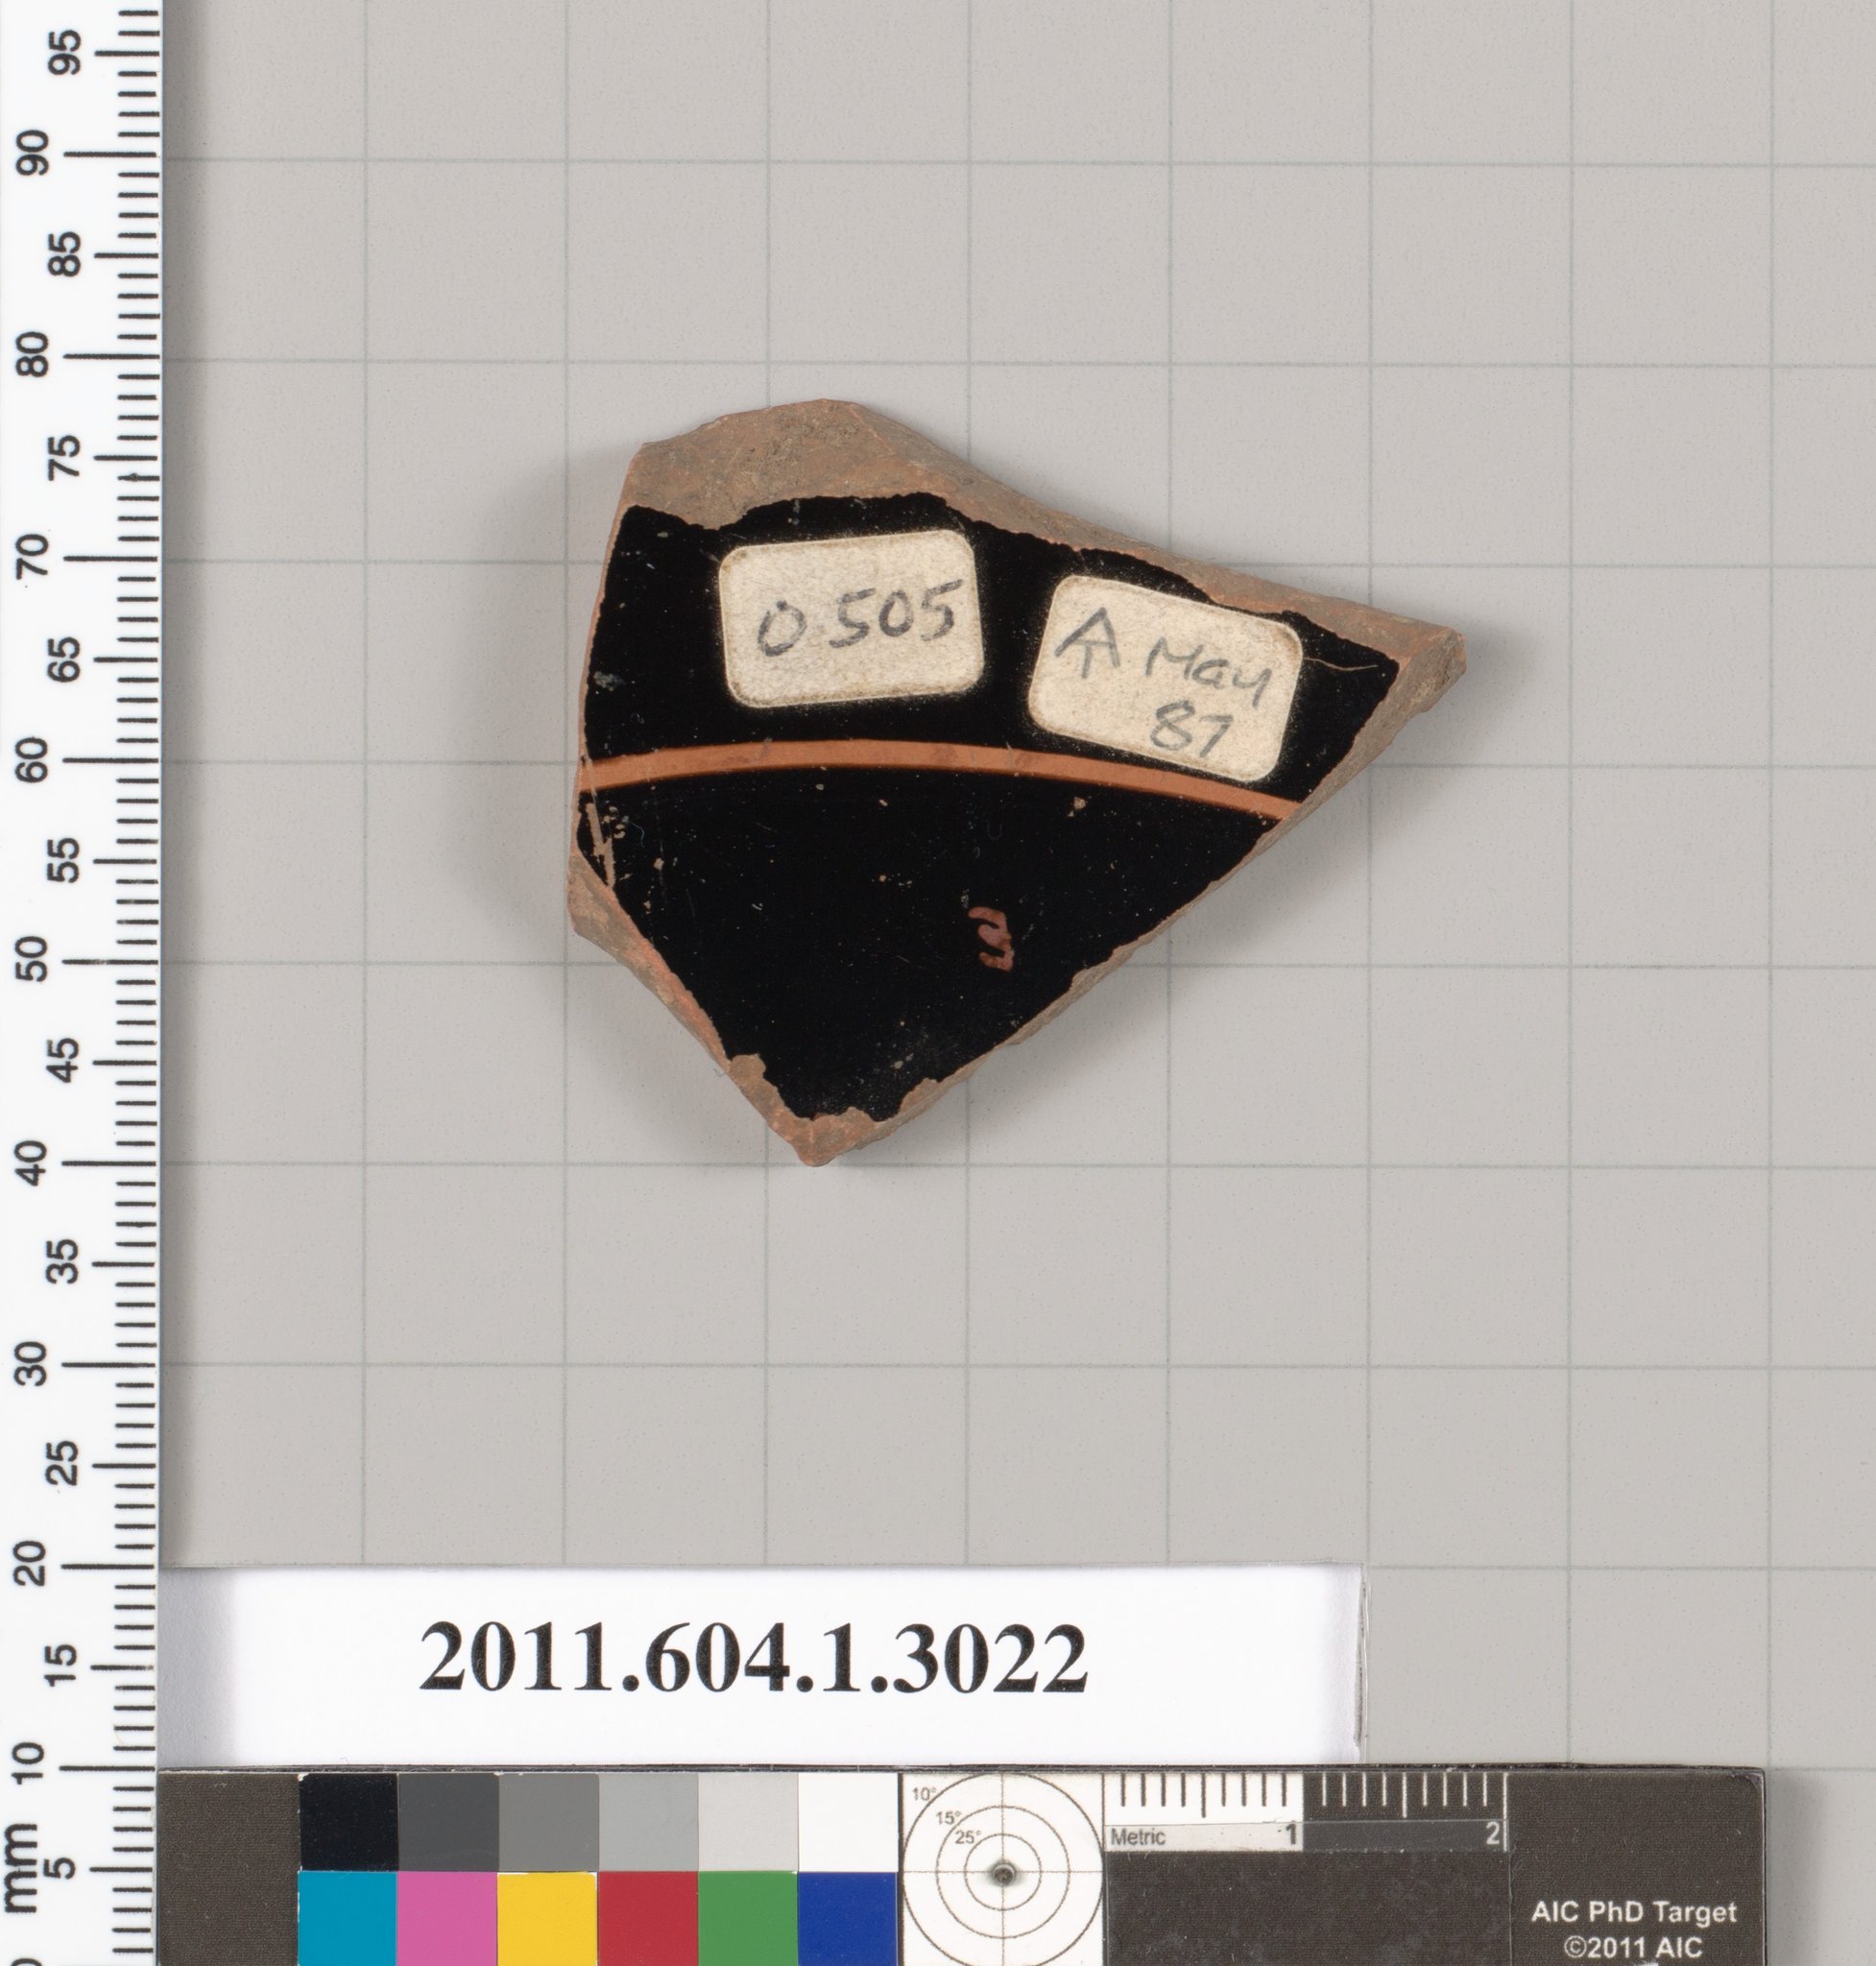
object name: kylix fragment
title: Terracotta fragment of a kylix (drinking cup)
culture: greek, attic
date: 510-490 BCE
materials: terracotta